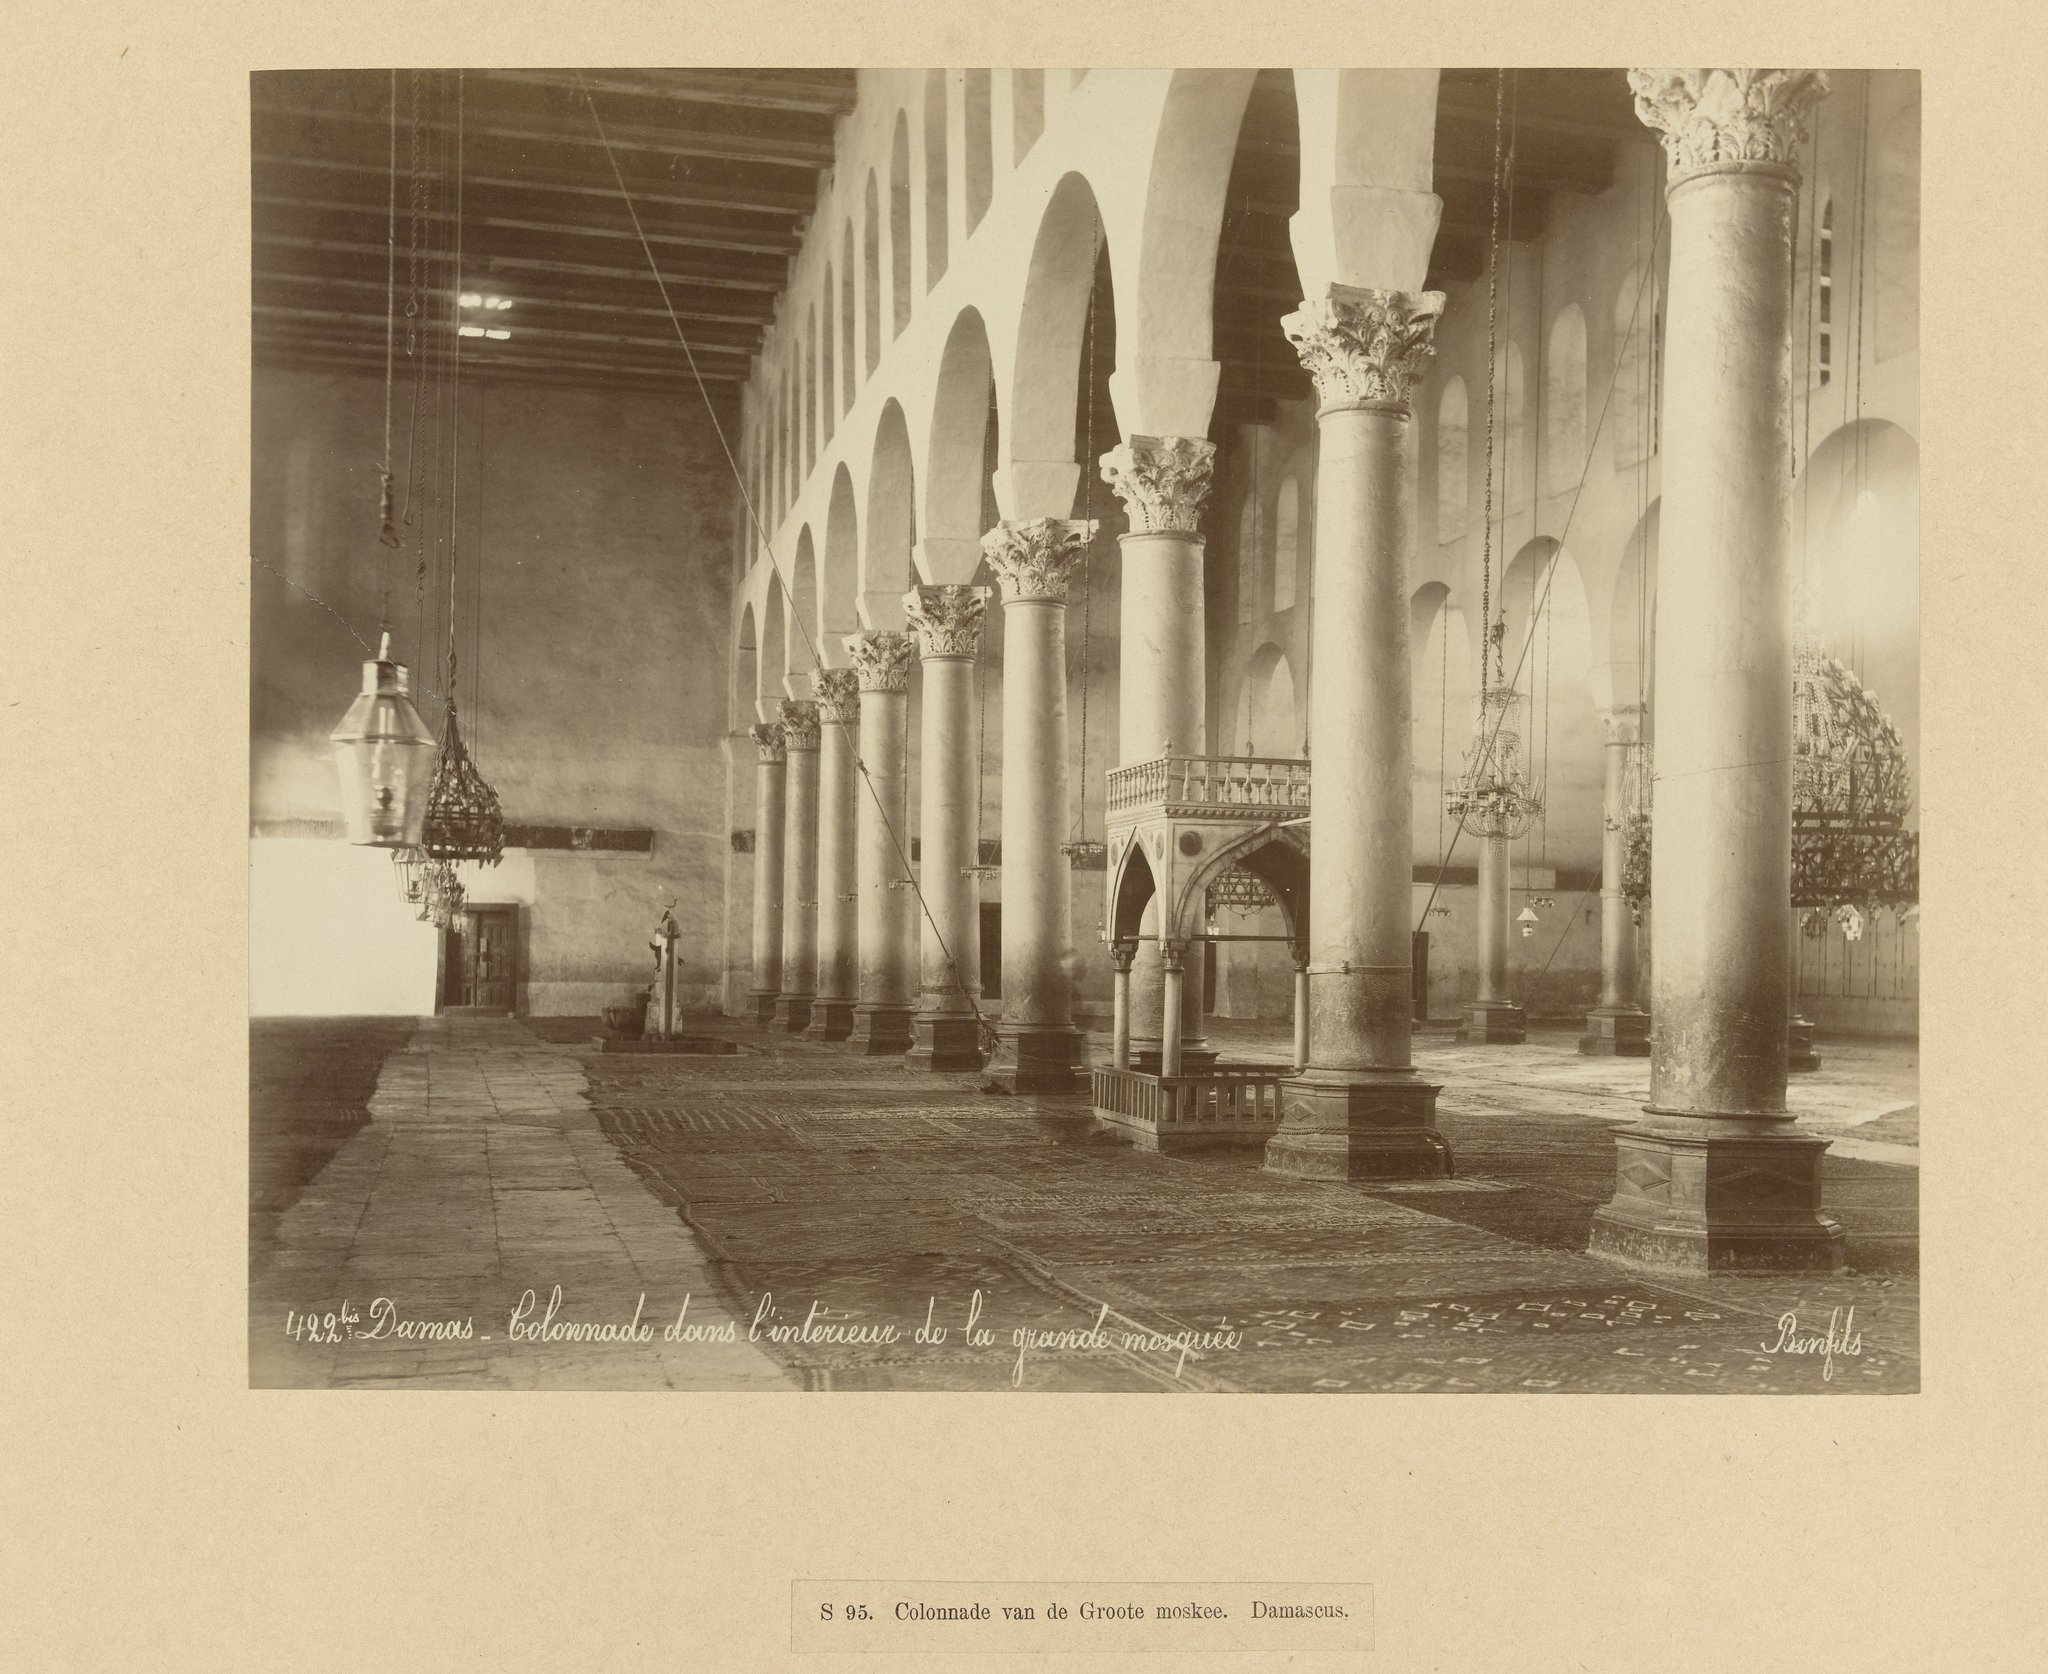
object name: photograph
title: Damas. Colonnade dans l'intérieur de la grande mosquée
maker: félix bonfils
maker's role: fotograaf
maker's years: 1831-1885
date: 1867-1877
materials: cardboard, paper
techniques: albumen print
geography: damascus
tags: temple, shrine ~ islam, mohammedanism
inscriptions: stamp: ‘Gemeentelijke bibliotheek/ Rotterdam’, number: ‘422bis’, check stamp: ‘Bristol/ L.M.’, title: ‘S 95. Colonnade van de Groote moskee. Damascus.’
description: Onderdeel van een groep door fotograaf Richard Polak op reis verzamelde foto’s. Deze foto is samen met andere op zijn reizen verzamelde foto's tentoongesteld bij de Rotterdamsche Kunstkring (1895), Arti en Amicitiae te Amsterdam (1897-1898?) en Societeit 't Collegie te Kampen (datum vooralsnog onbekend).